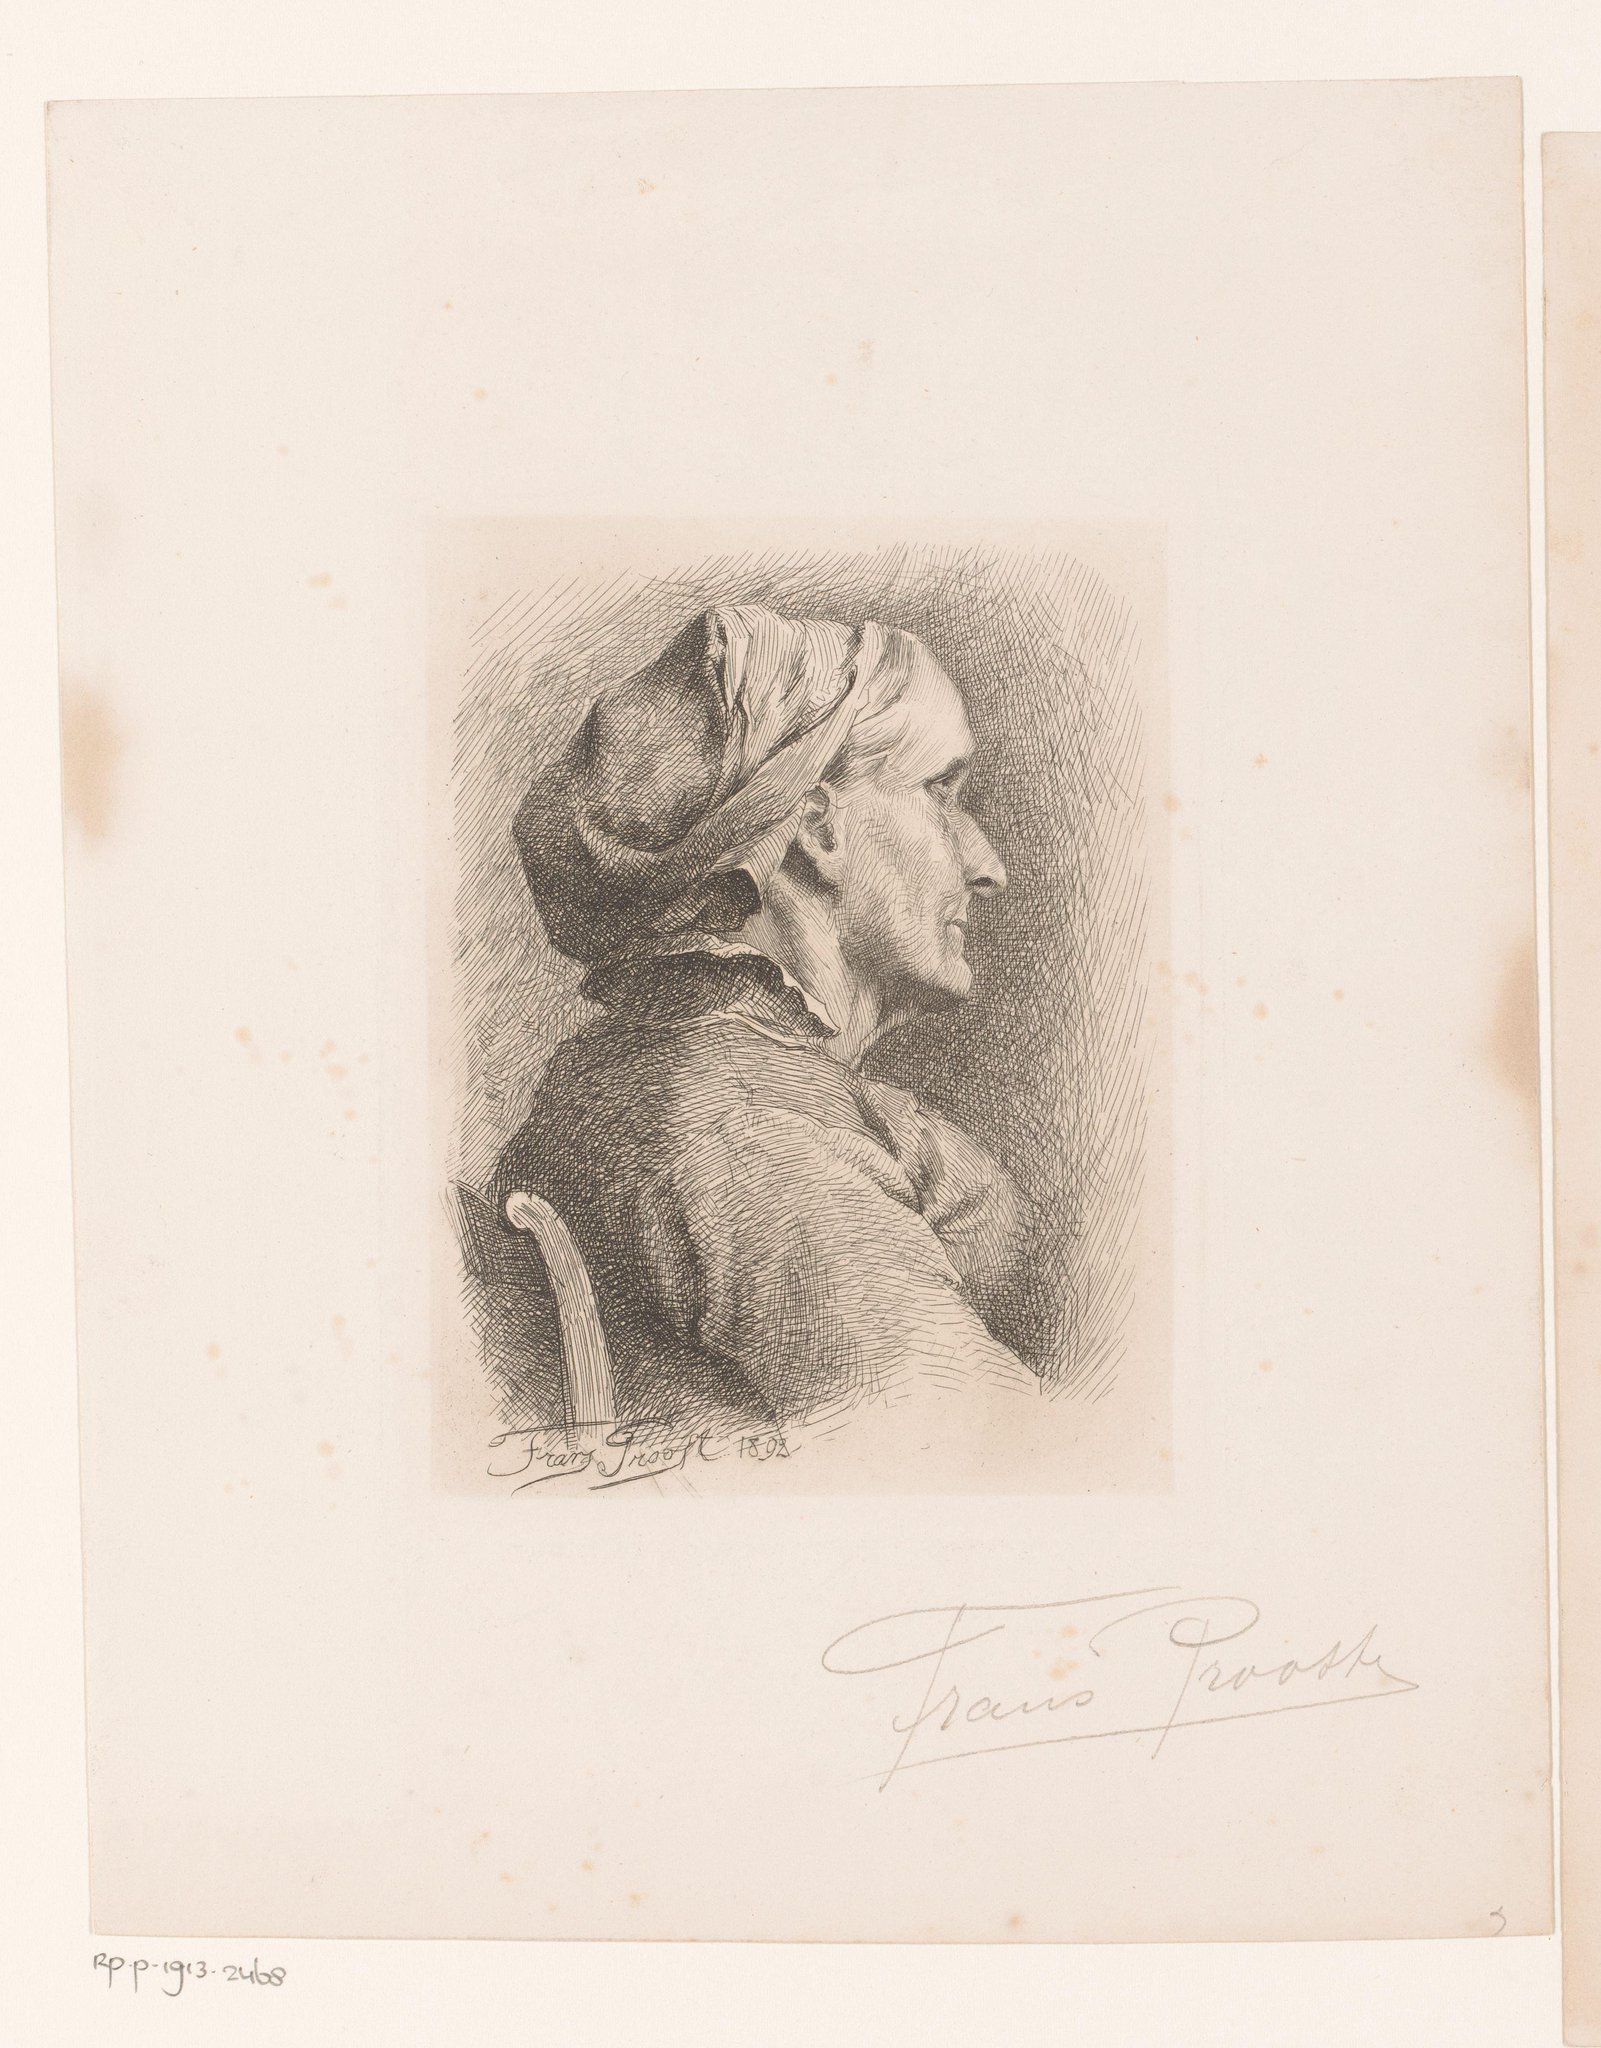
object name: print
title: Portret van een onbekende oude vrouw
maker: frans proost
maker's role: painter, print maker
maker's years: 1875-1941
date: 1892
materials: paper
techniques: etching, intaglio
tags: anonymous historical person portrayed alone - bb - woman, old woman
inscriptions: collector's mark: Lugt 2228